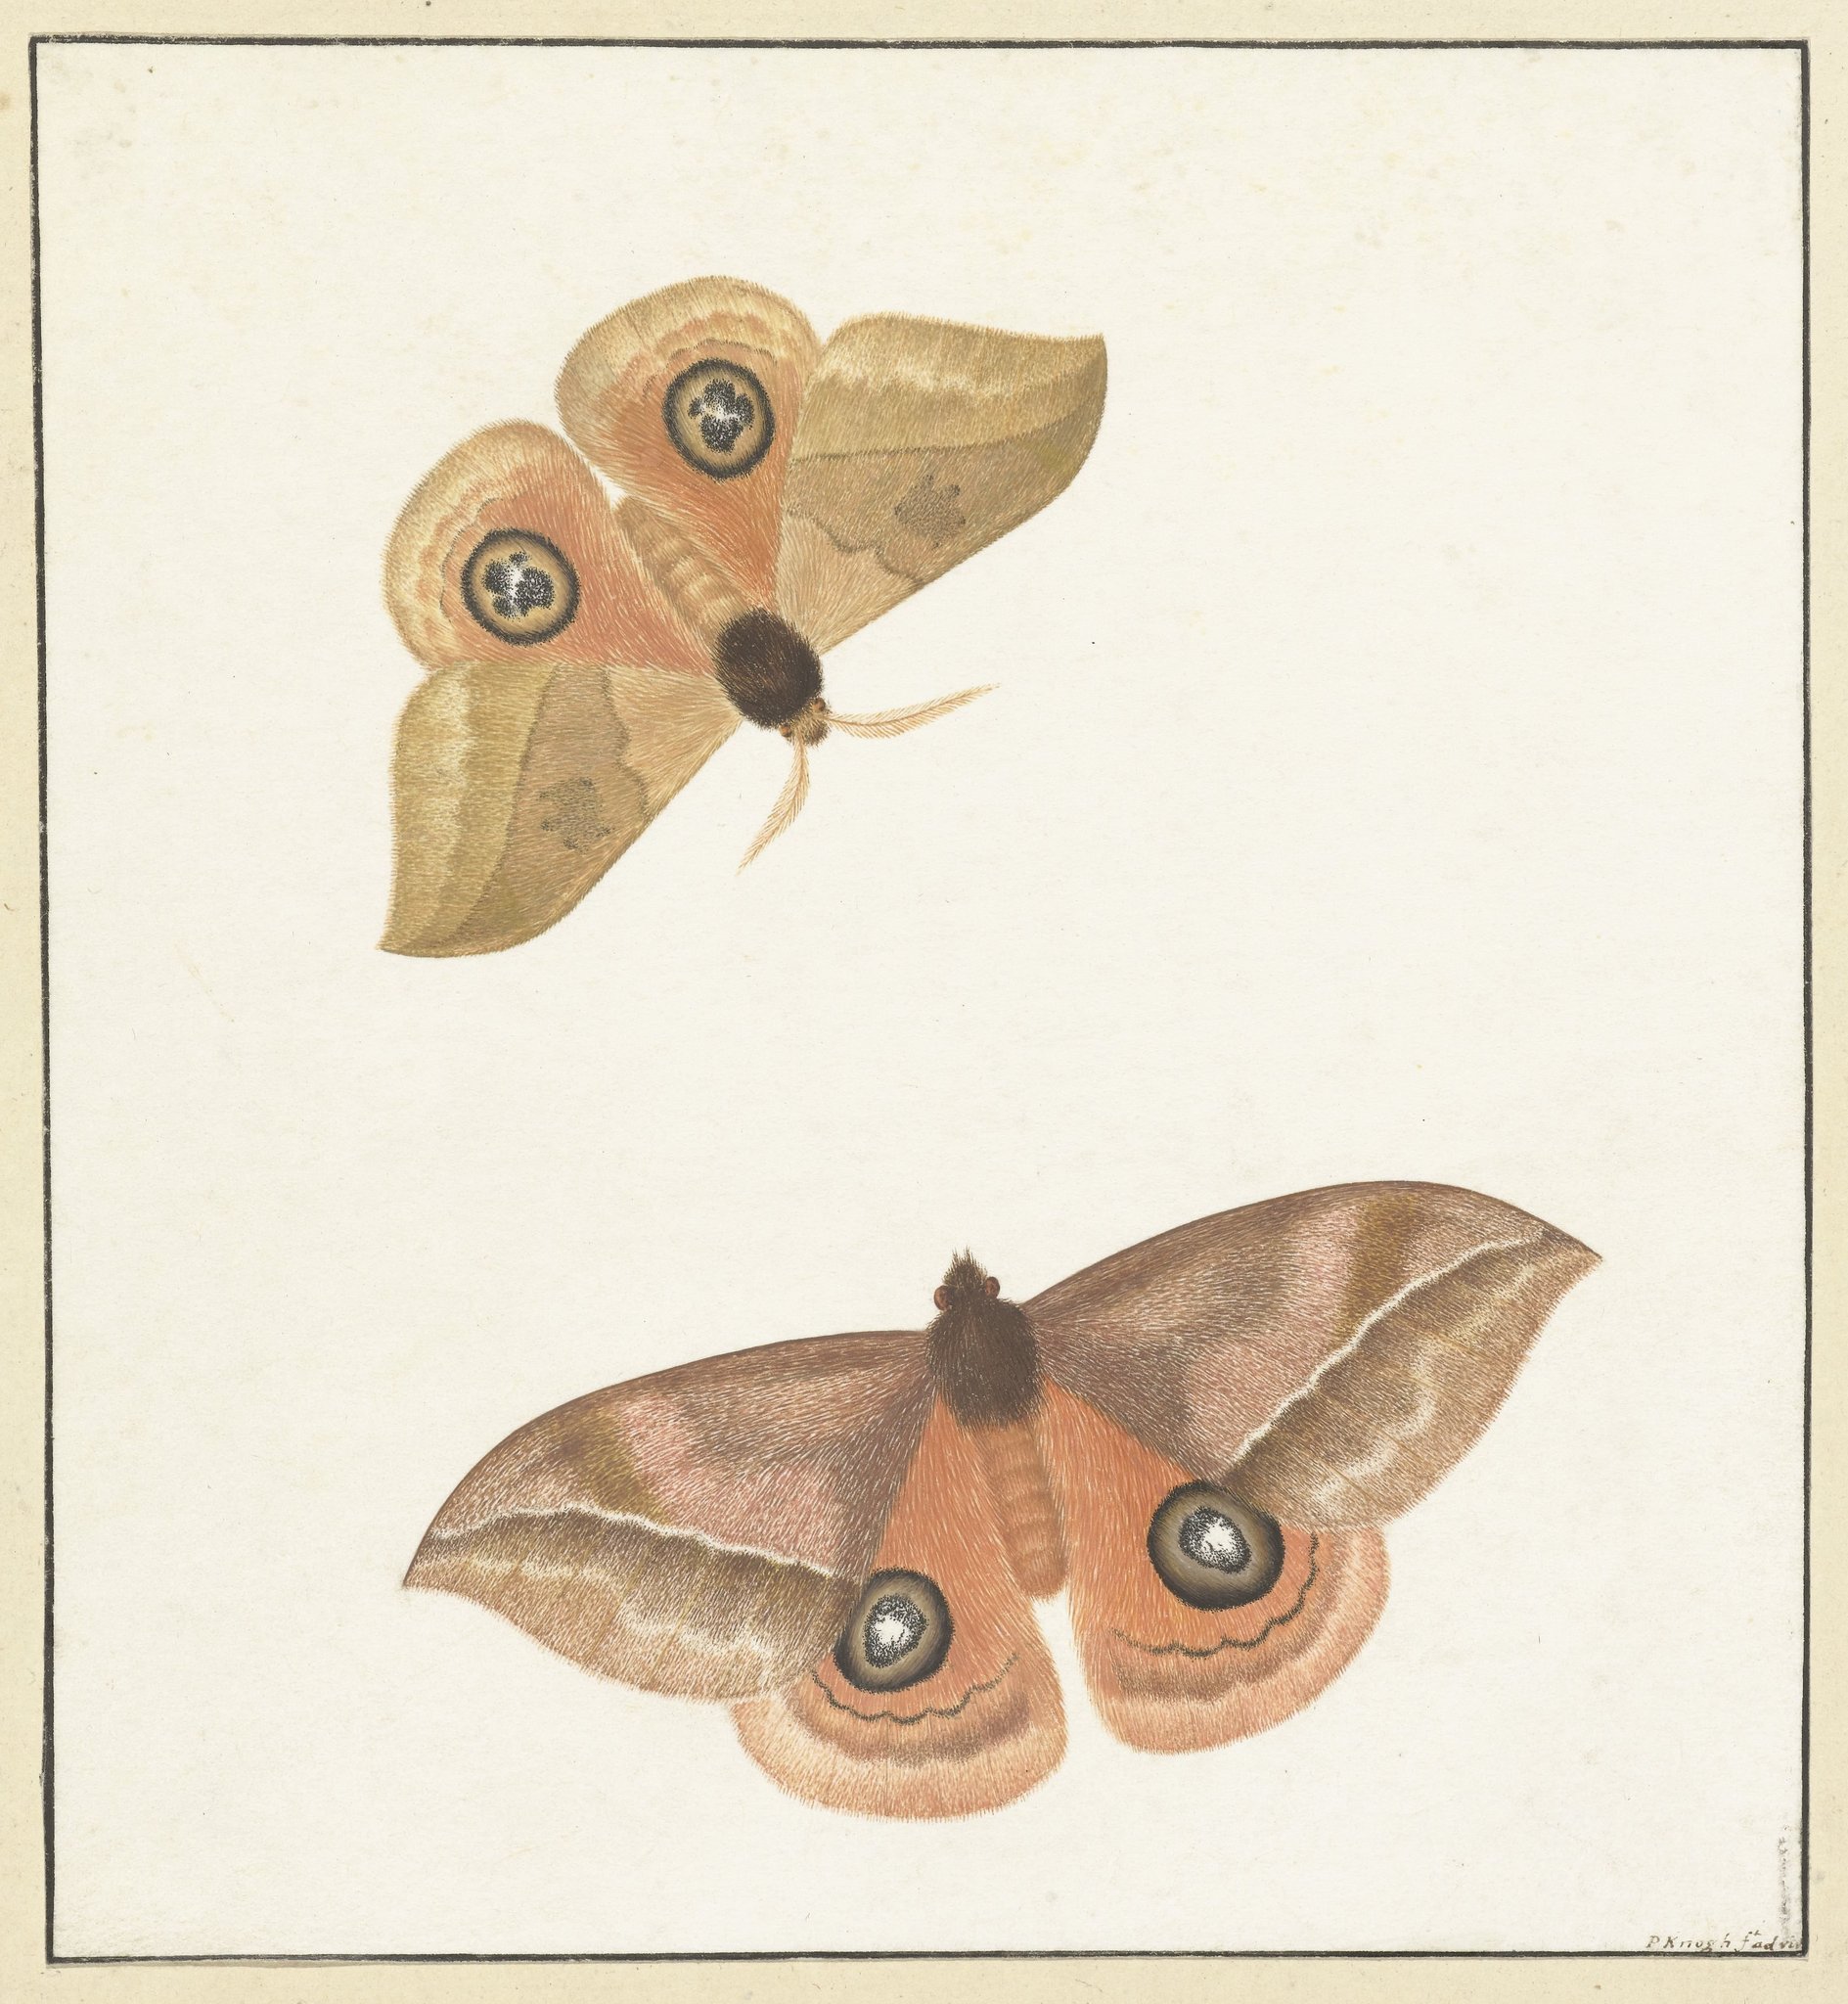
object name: drawing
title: Twee vlinders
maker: paulus knogh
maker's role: draughtsman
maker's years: 1737-1802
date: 1747-1802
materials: paint, paper, watercolor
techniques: brush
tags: insects: butterfly